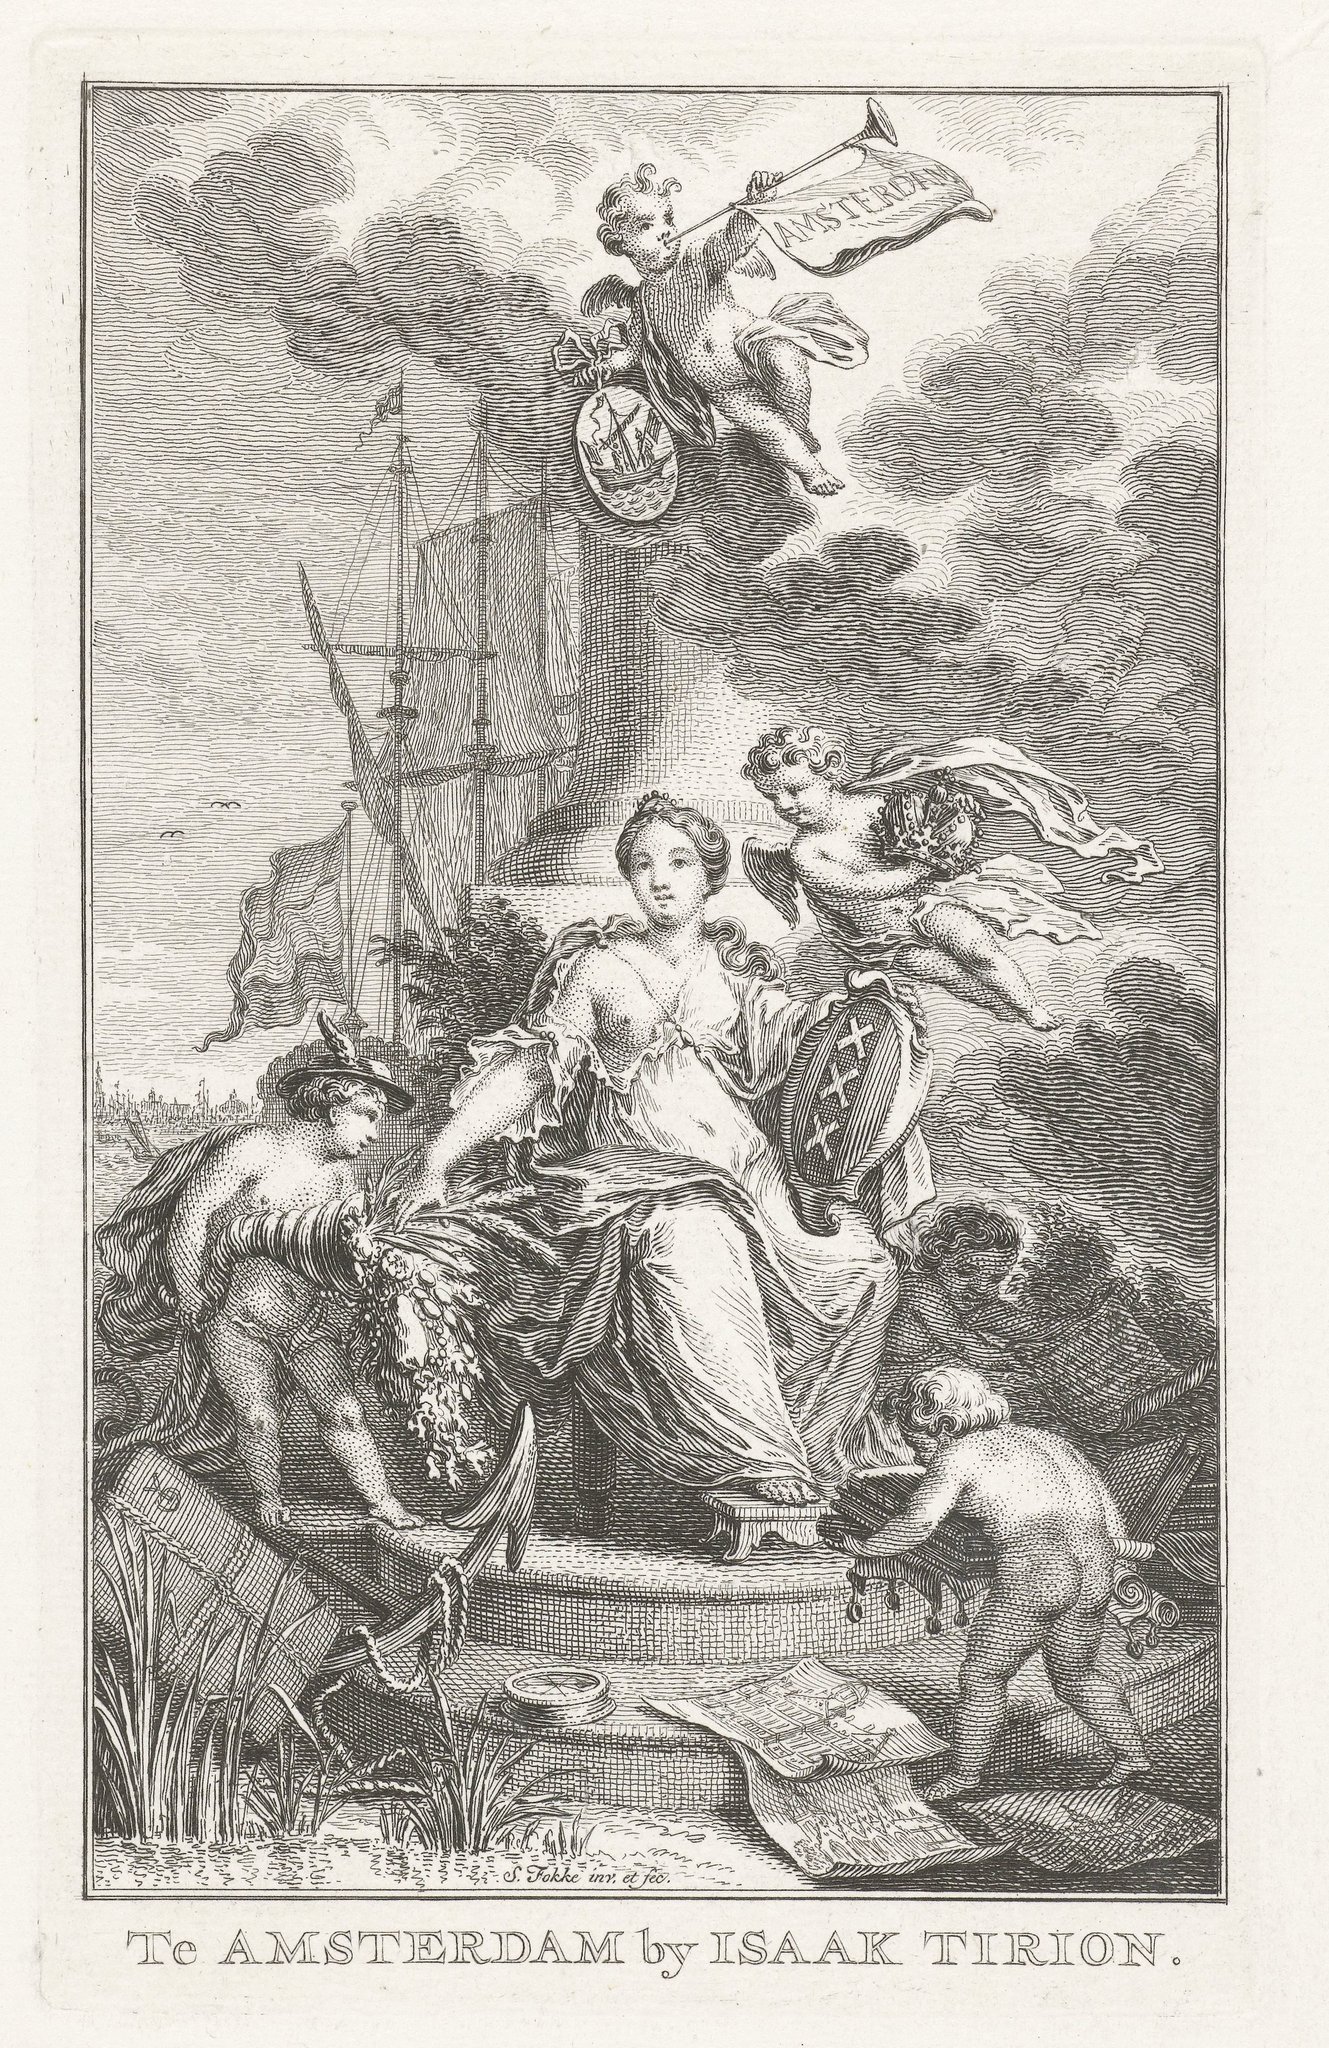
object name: print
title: Amsterdamse Stedenmaagd omringd door putti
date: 1729-1766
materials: paper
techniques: etching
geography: amsterdam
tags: personification of a city, town-patron(ess), cupids: 'amores', 'amoretti', 'putti', amsterdam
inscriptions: collector's mark: Lugt 2228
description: Op een verhoging zit de Amsterdamse Stedenmaagd met het wapen van Amsterdam. Ze heeft haar arm uitgestrekt naar de hoorn des overvloeds die wordt vastgehouden door een putto met gevleugelde helm. Rechts van haar vliegt een putto met een kroon in zijn handen, voor haar knielt een putto met een boek op een kussentje. Boven in de lucht wordt de bazuin geblazen door een putto die een medaillon met de beeltenis van een zeilschip vasthoudt.